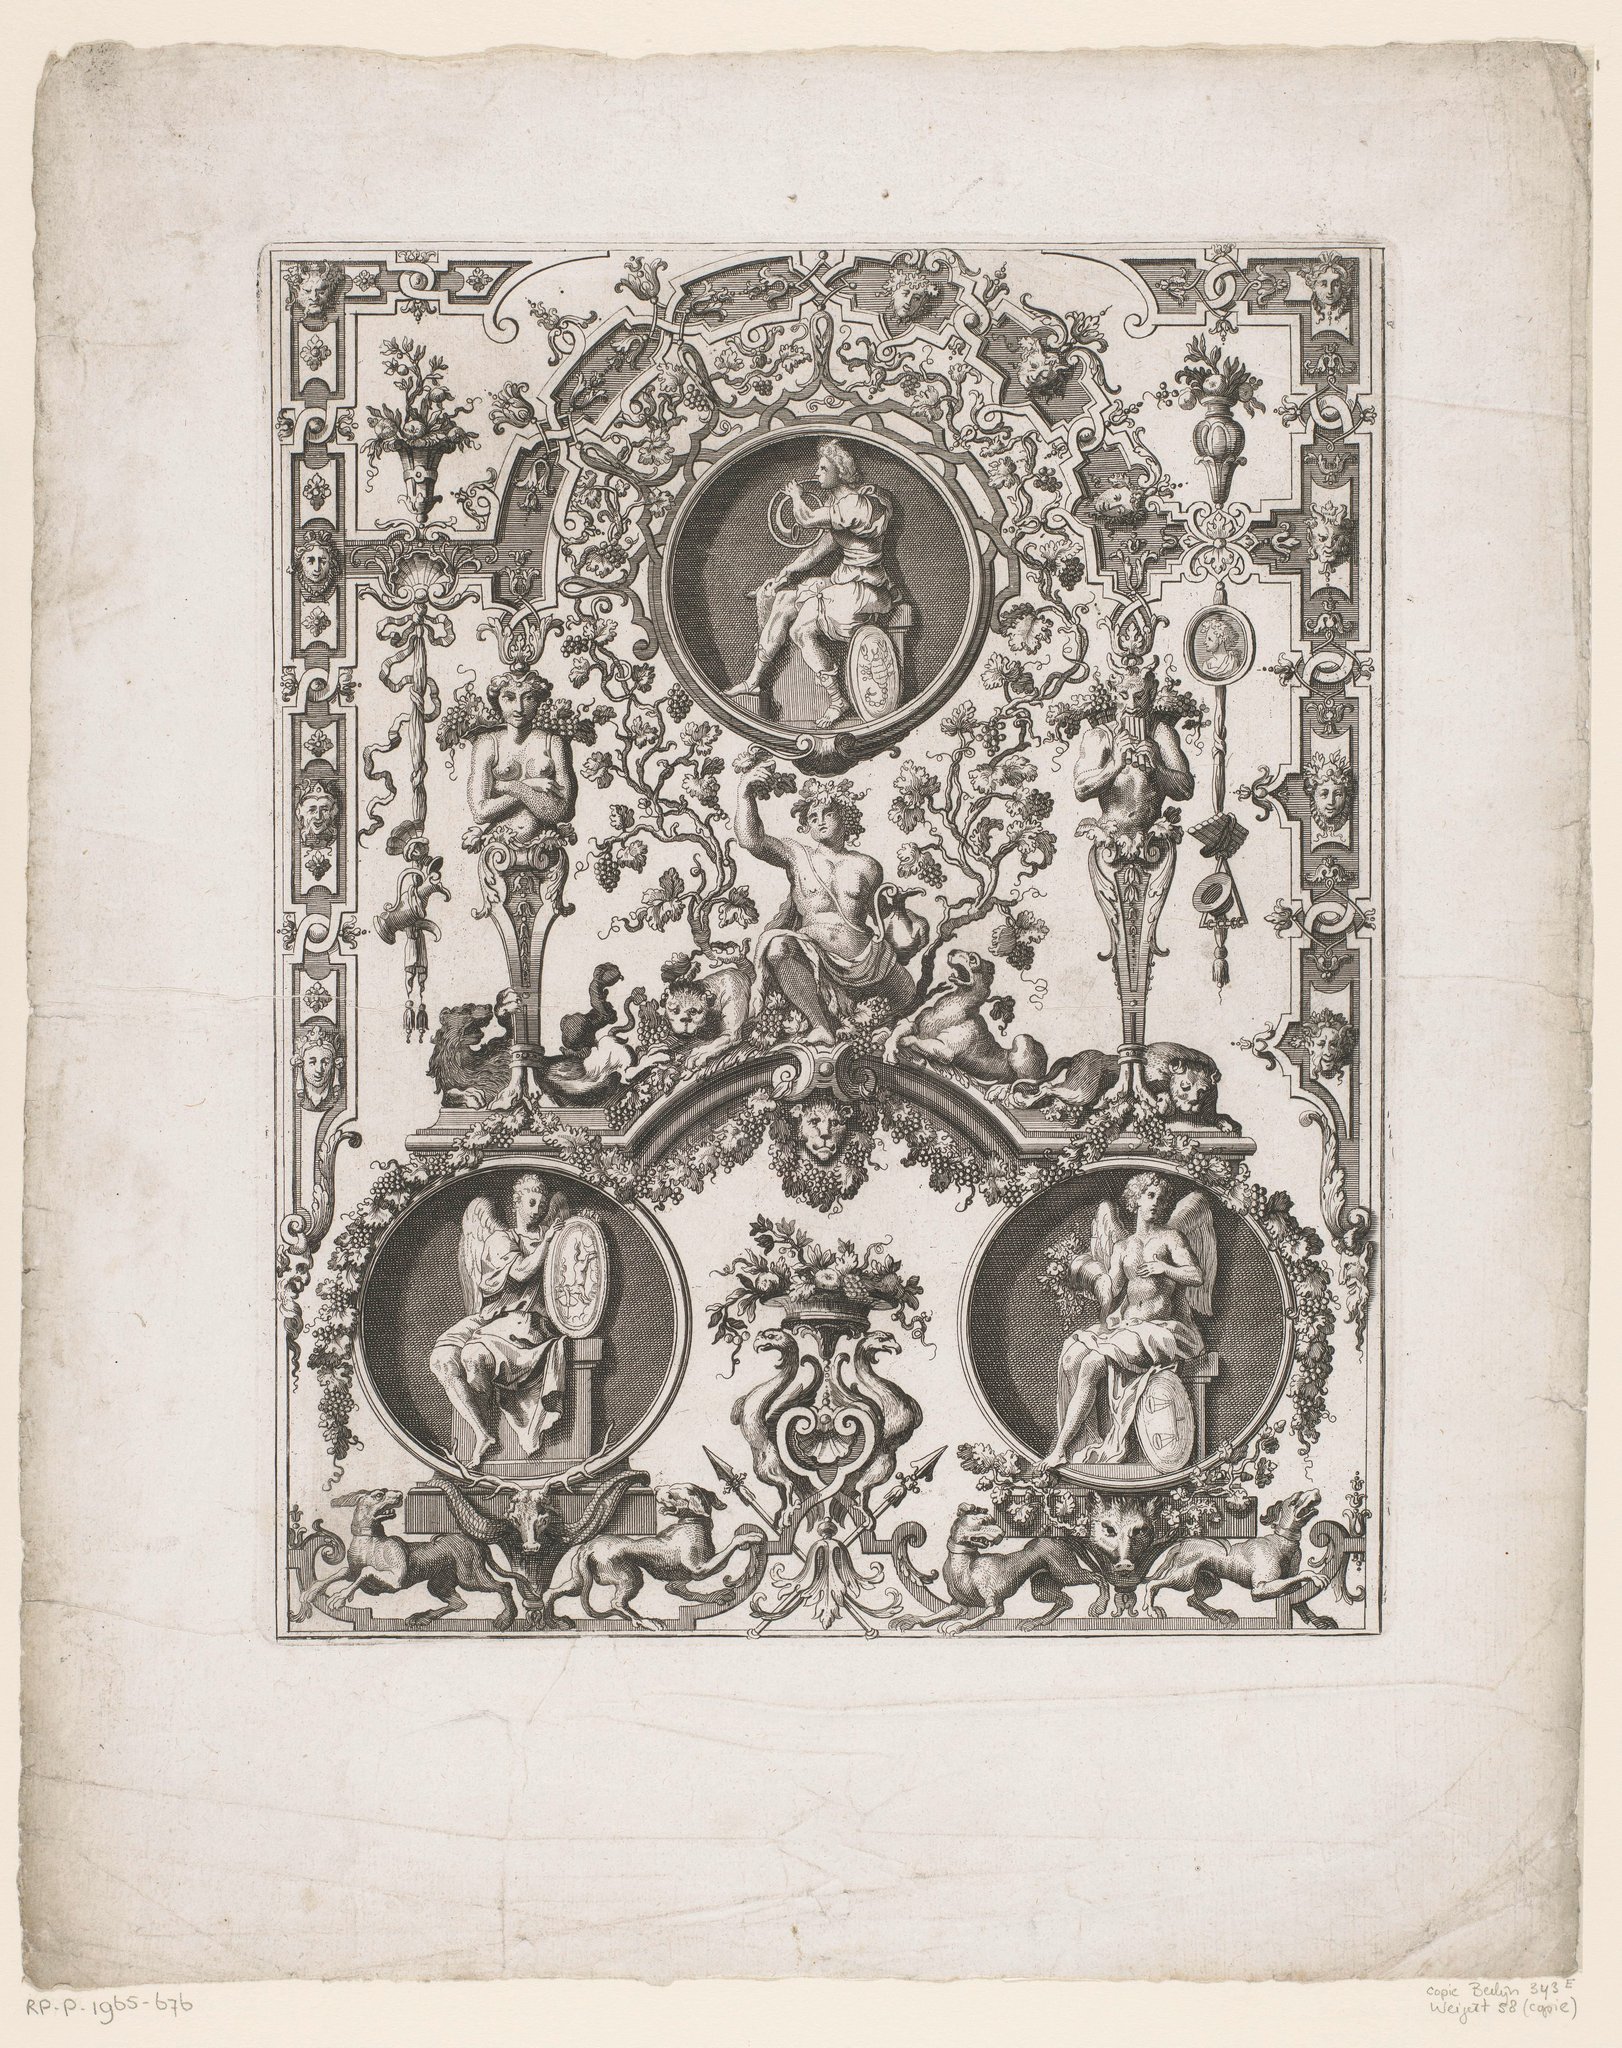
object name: print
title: Herfst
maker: Anonymous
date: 1686-1724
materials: paper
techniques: etching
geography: augsburg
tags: autumn, fall, 'autumnus'; 'autunno' (ripa)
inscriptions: collector's mark: Lugt 2228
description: Allegorische voorstelling van de herfst. Een decoratie compositie met drie medaillons met personificaties van de maanden september, oktober en november met bijbehorende tekens van de dierenriem. In het midden op een arcade zit Bacchus omgeven door wijnranken tussen twee kariatiden. Aan weerszijden van Bacchus liggen katachtigen. Onder de arcade wordt een vaas gedragen door twee adelaars. Aan de onderzijde vier honden.